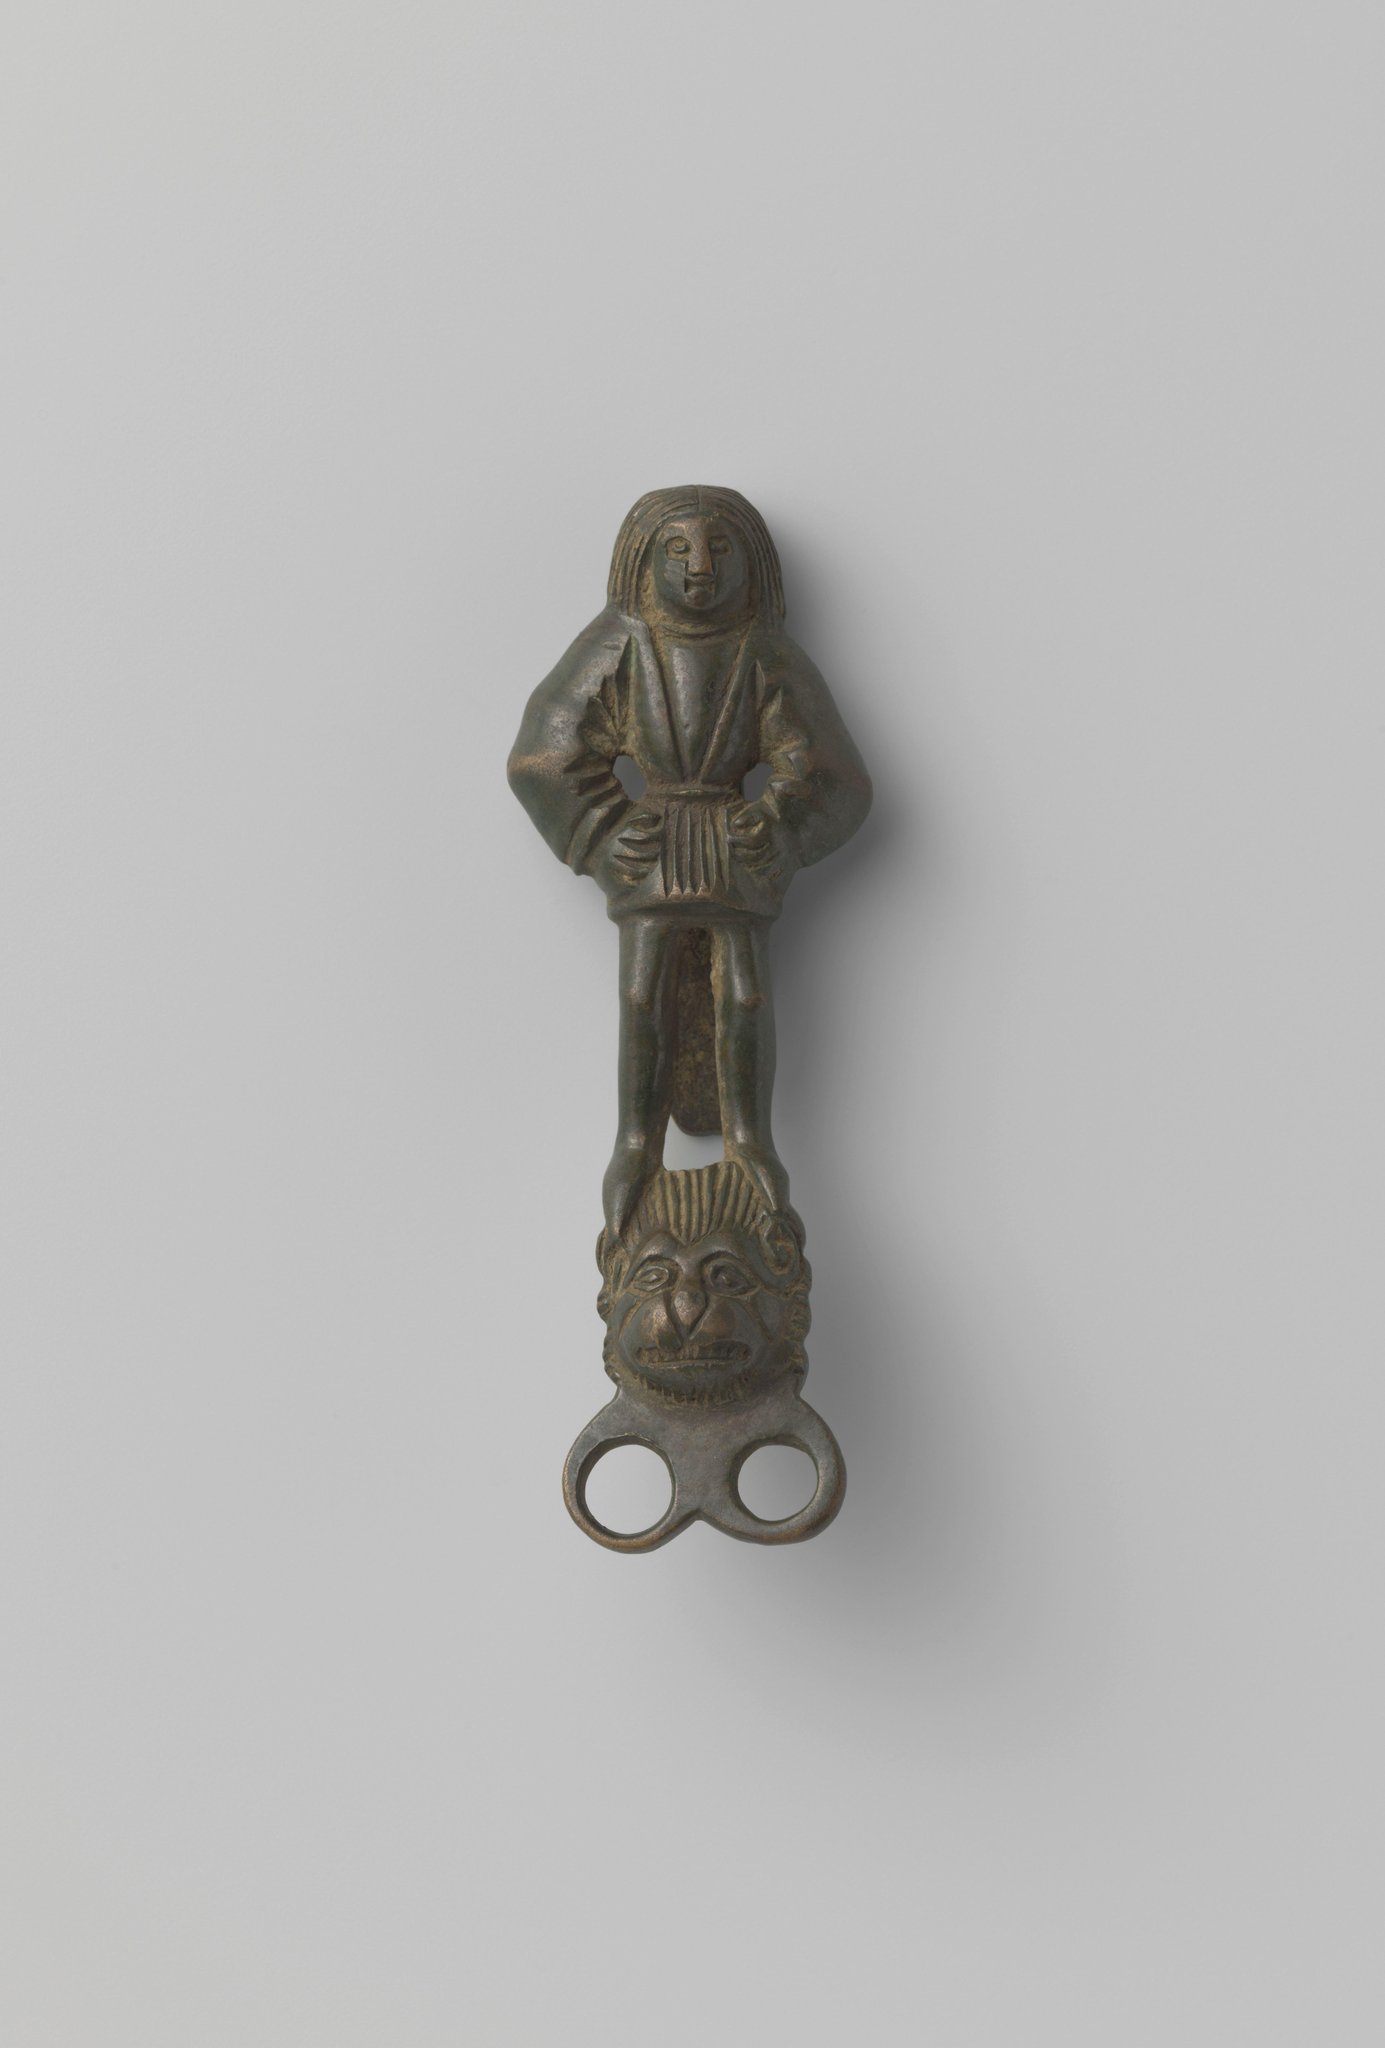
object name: hook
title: Haak in de vorm van een mansfiguur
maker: Anonymous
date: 1400-1500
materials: brass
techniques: casting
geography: nuremberg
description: Het als één geheel gegoten voorwerp stelt een in hoze en wambuis geklede man voor, die op een leeuwenkop staat. Onder de leeuwenkop twee ogen, ter bevestiging van mogelijk een buidel. Aan de achterkant een lang smal verticaal gedeelte, om het geheel aan een riem te kunnen haken.